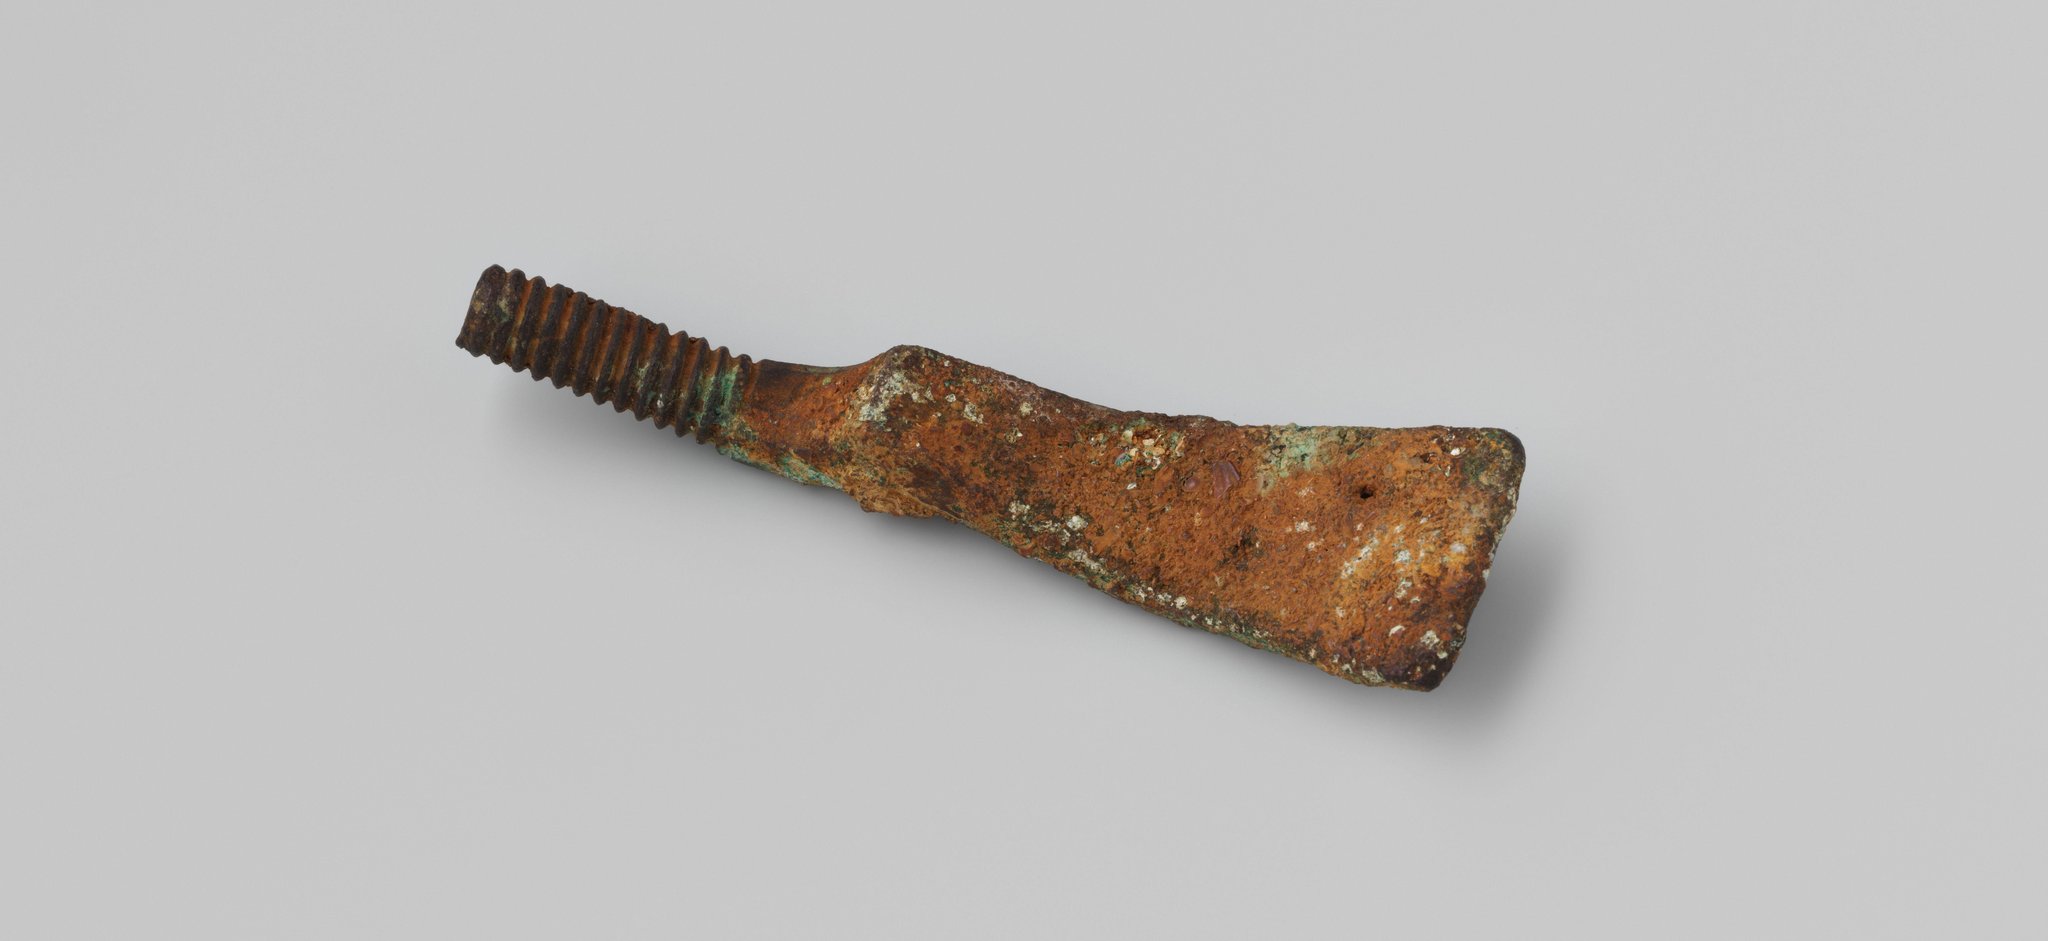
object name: bolt tongs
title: Bout afkomstig uit het wrak van de Oost-Indiëvaarder Hollandia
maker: Anonymous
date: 1700-1743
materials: copper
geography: netherlands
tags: verenigde oostindische compagnie, hollandia (schip)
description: Bolts; squashed, corroded, flat tapering plate, curving into a threaded shaft, 5 circular screw-holes in plate (id. 80H1911).